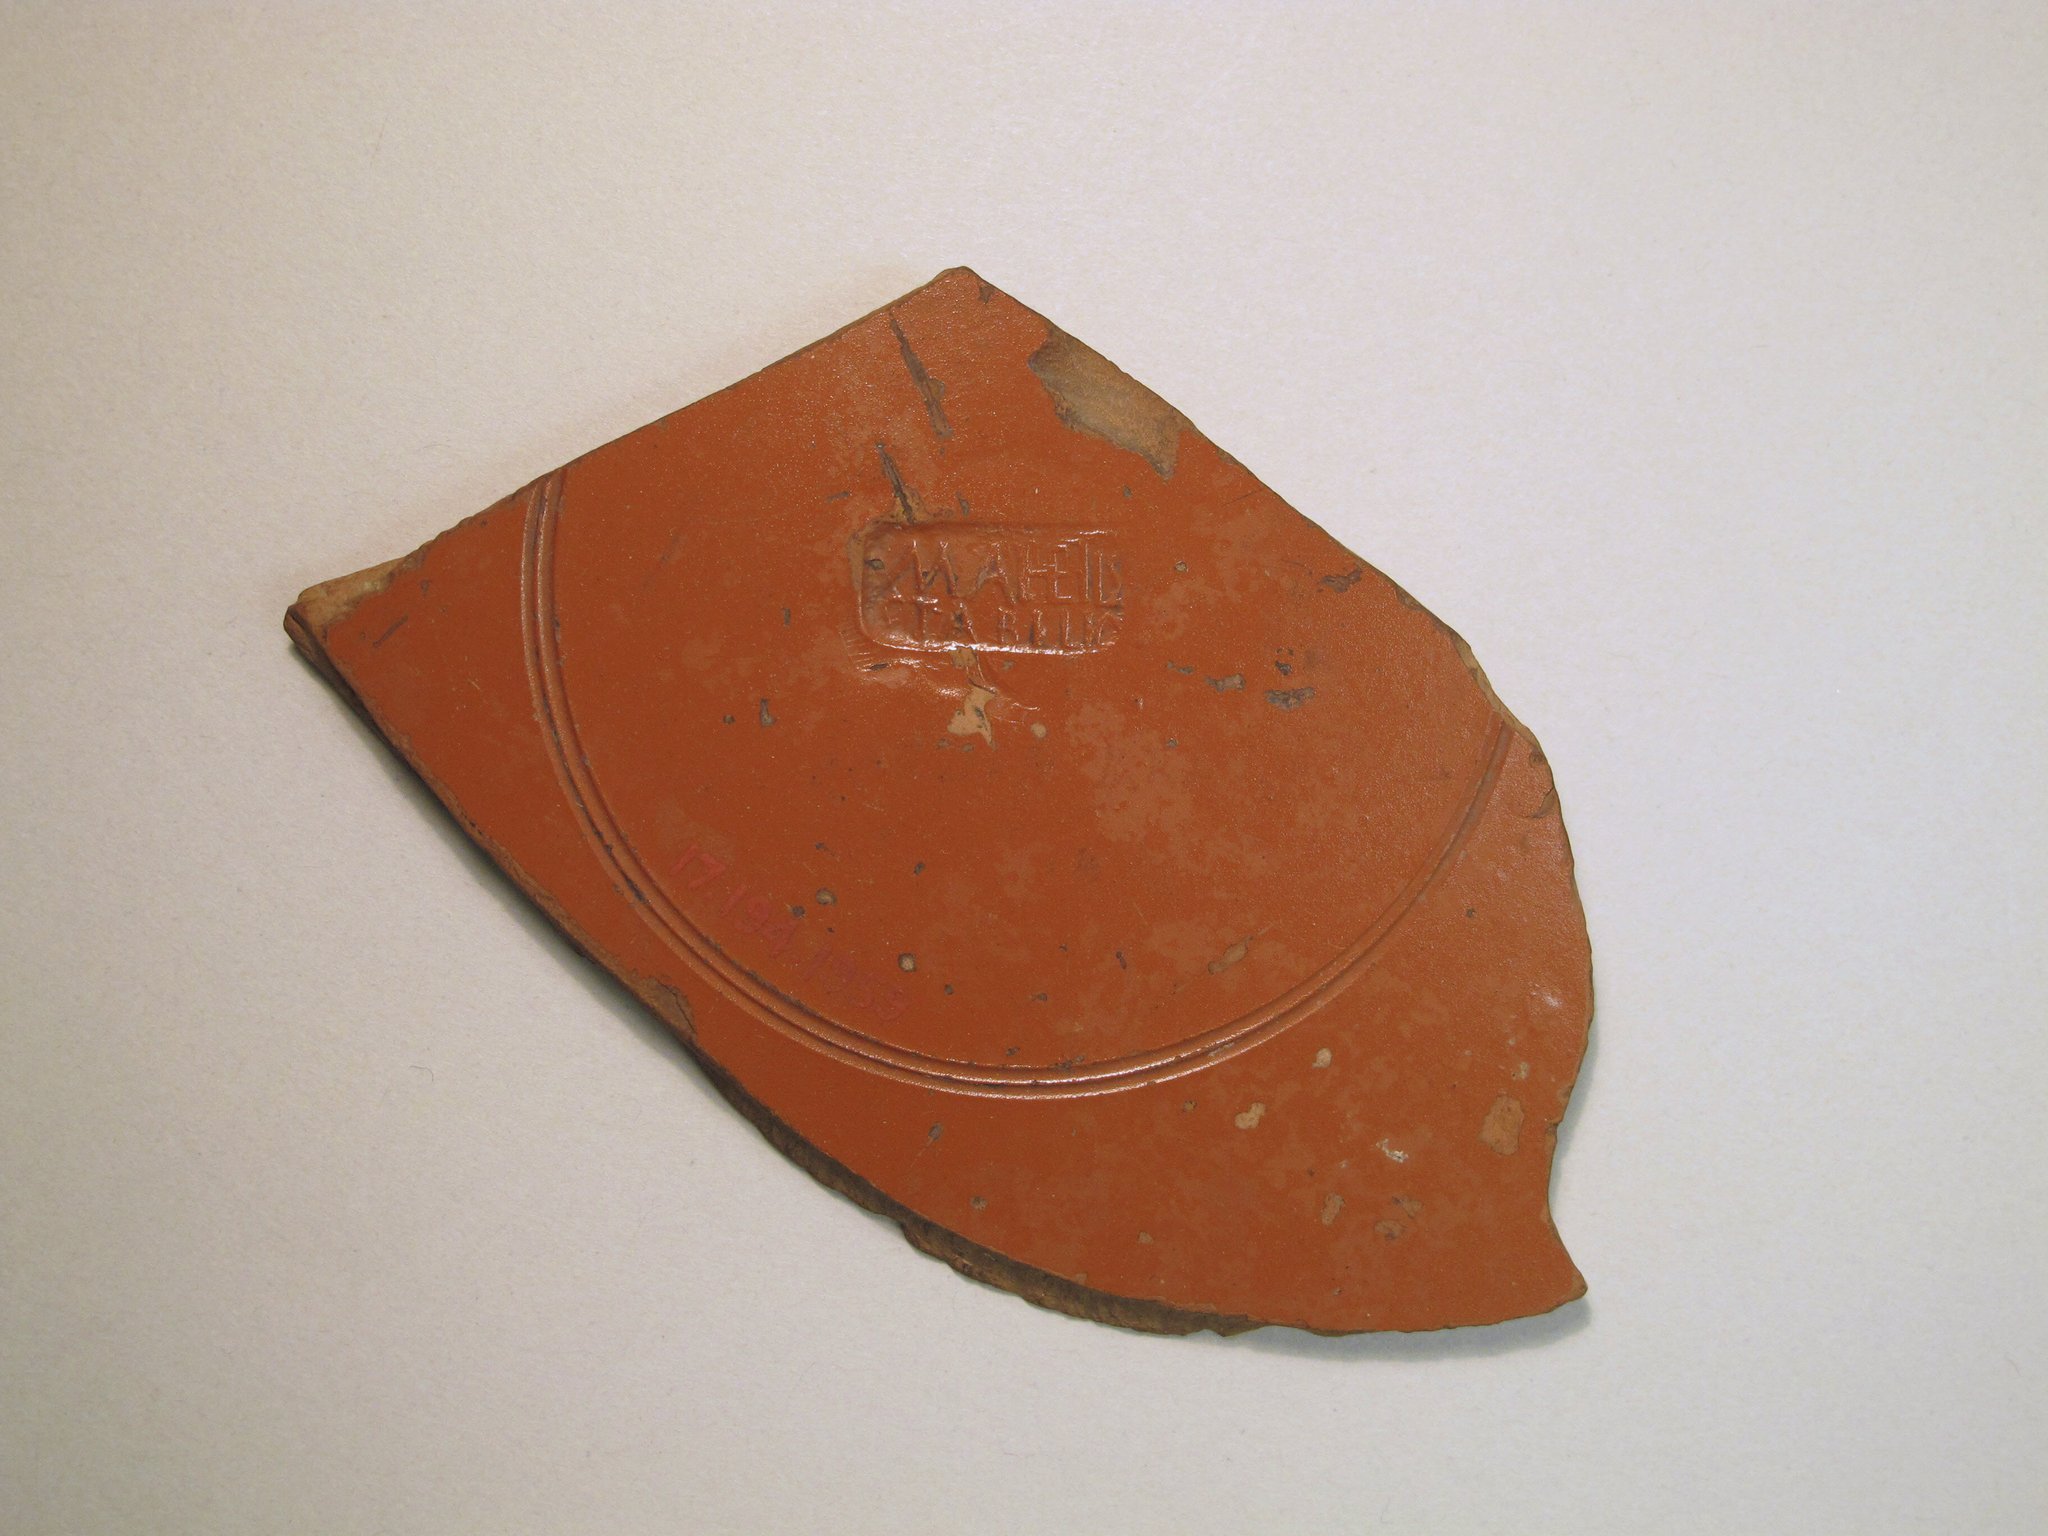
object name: vase fragment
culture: roman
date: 34-1 BCE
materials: terracotta